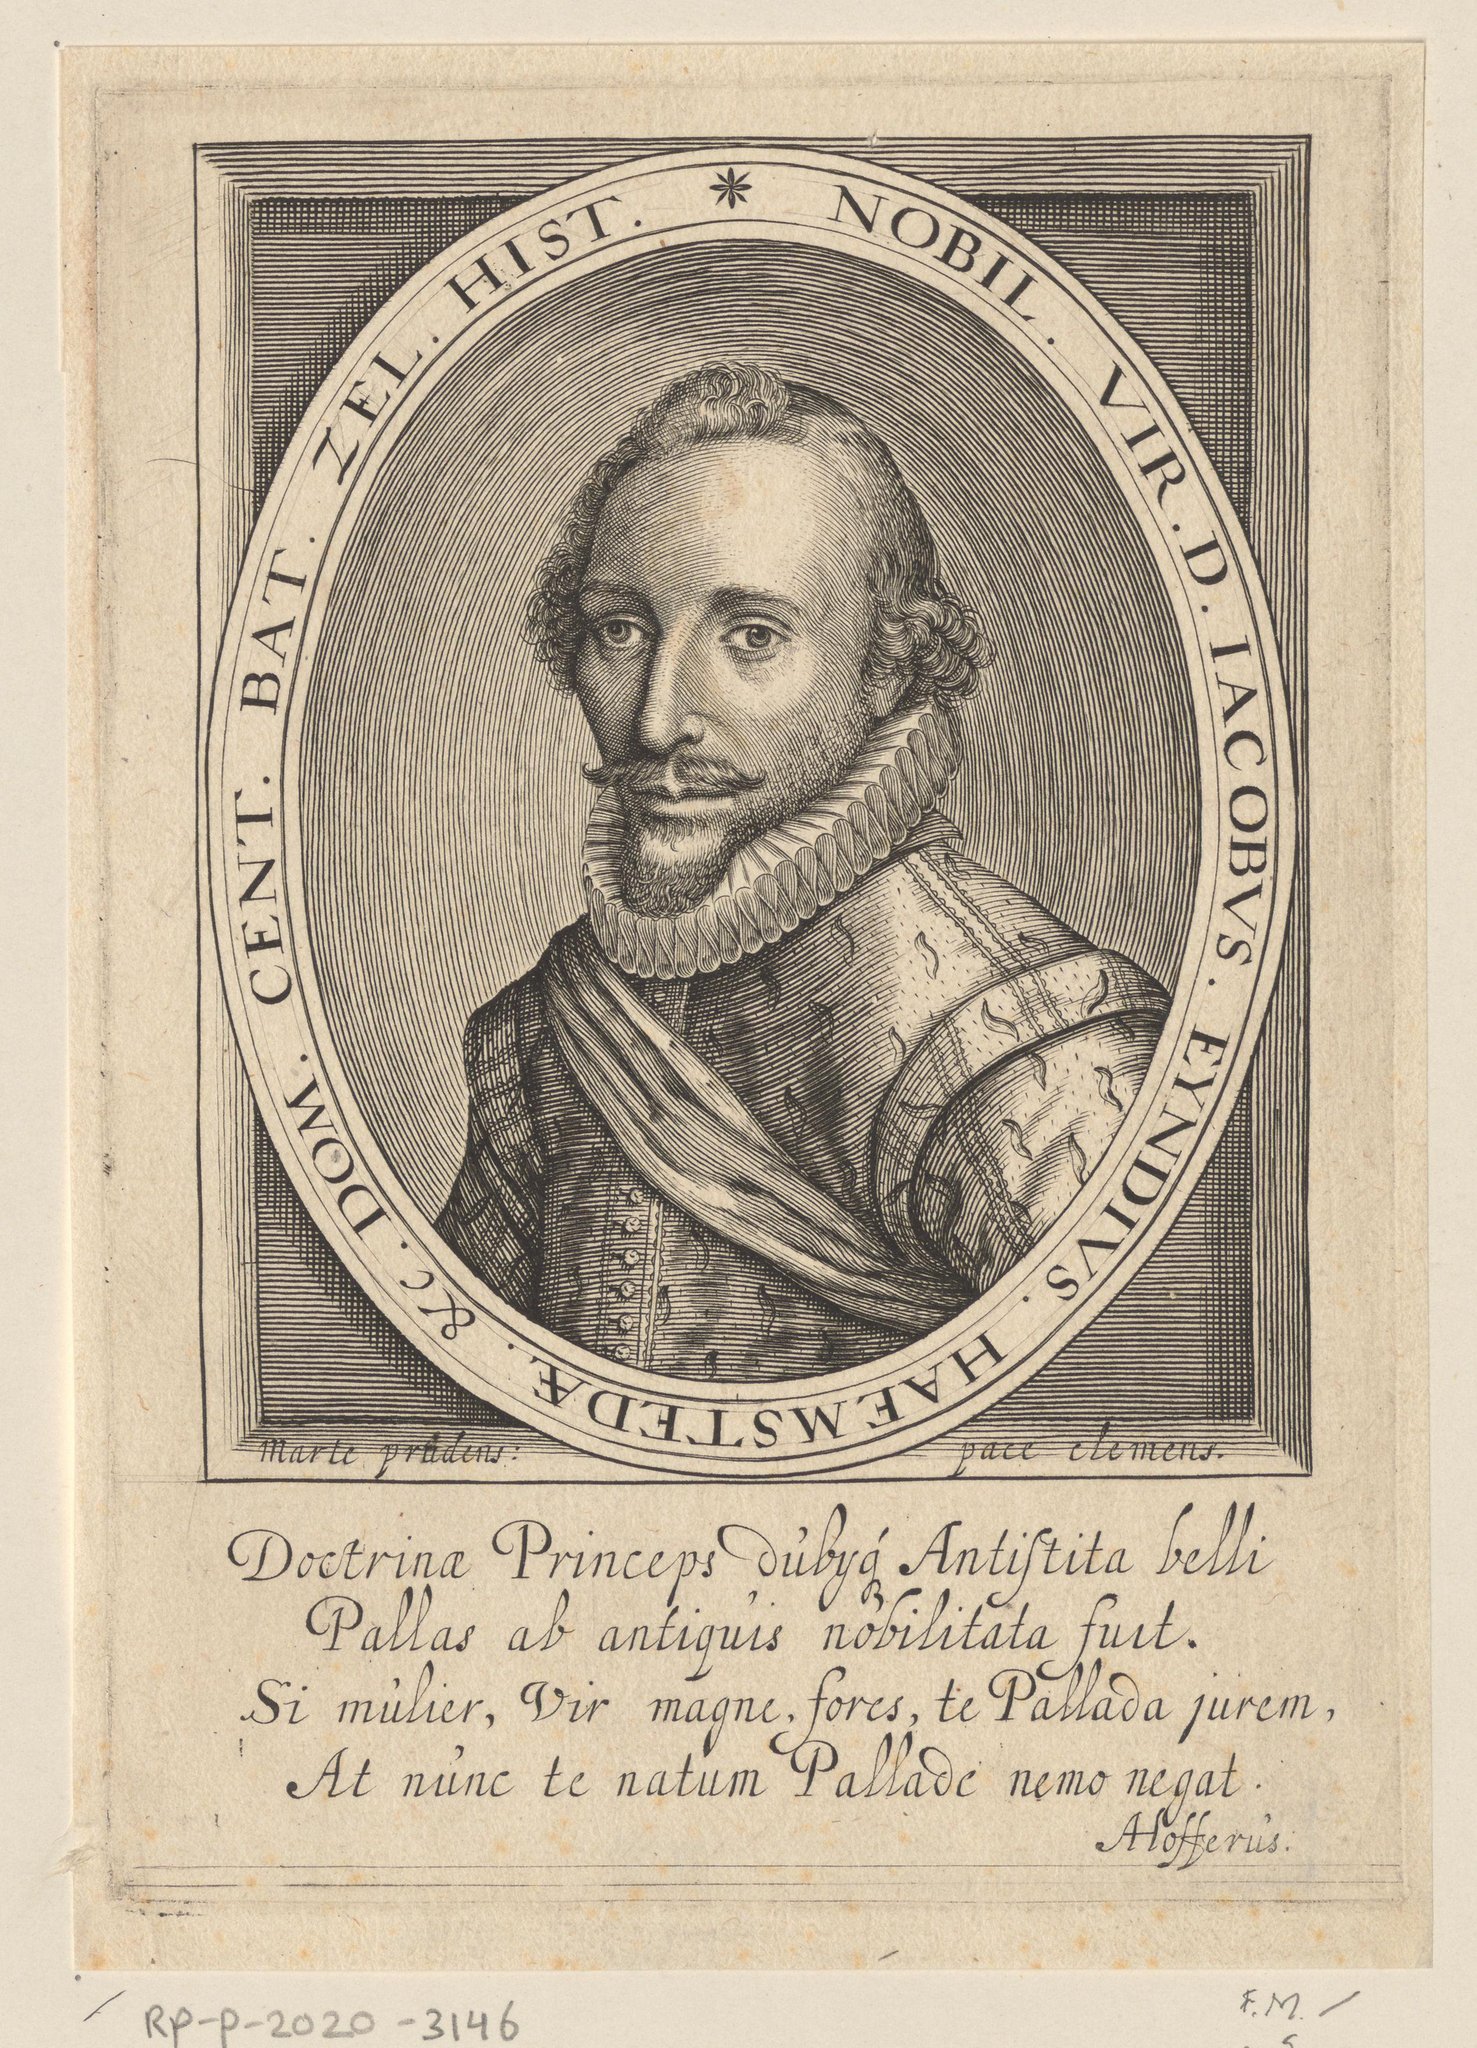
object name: print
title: Portret van Jacob van den Eynde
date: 1634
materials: paper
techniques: engraving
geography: northern netherlands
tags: delft, historical persons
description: Prent met tekst op verso gebruikt in: Eynde, Jacob van den. Chronici Zelandiae libri duo. Middelburg: weduwe Symon Moulert, 1634.